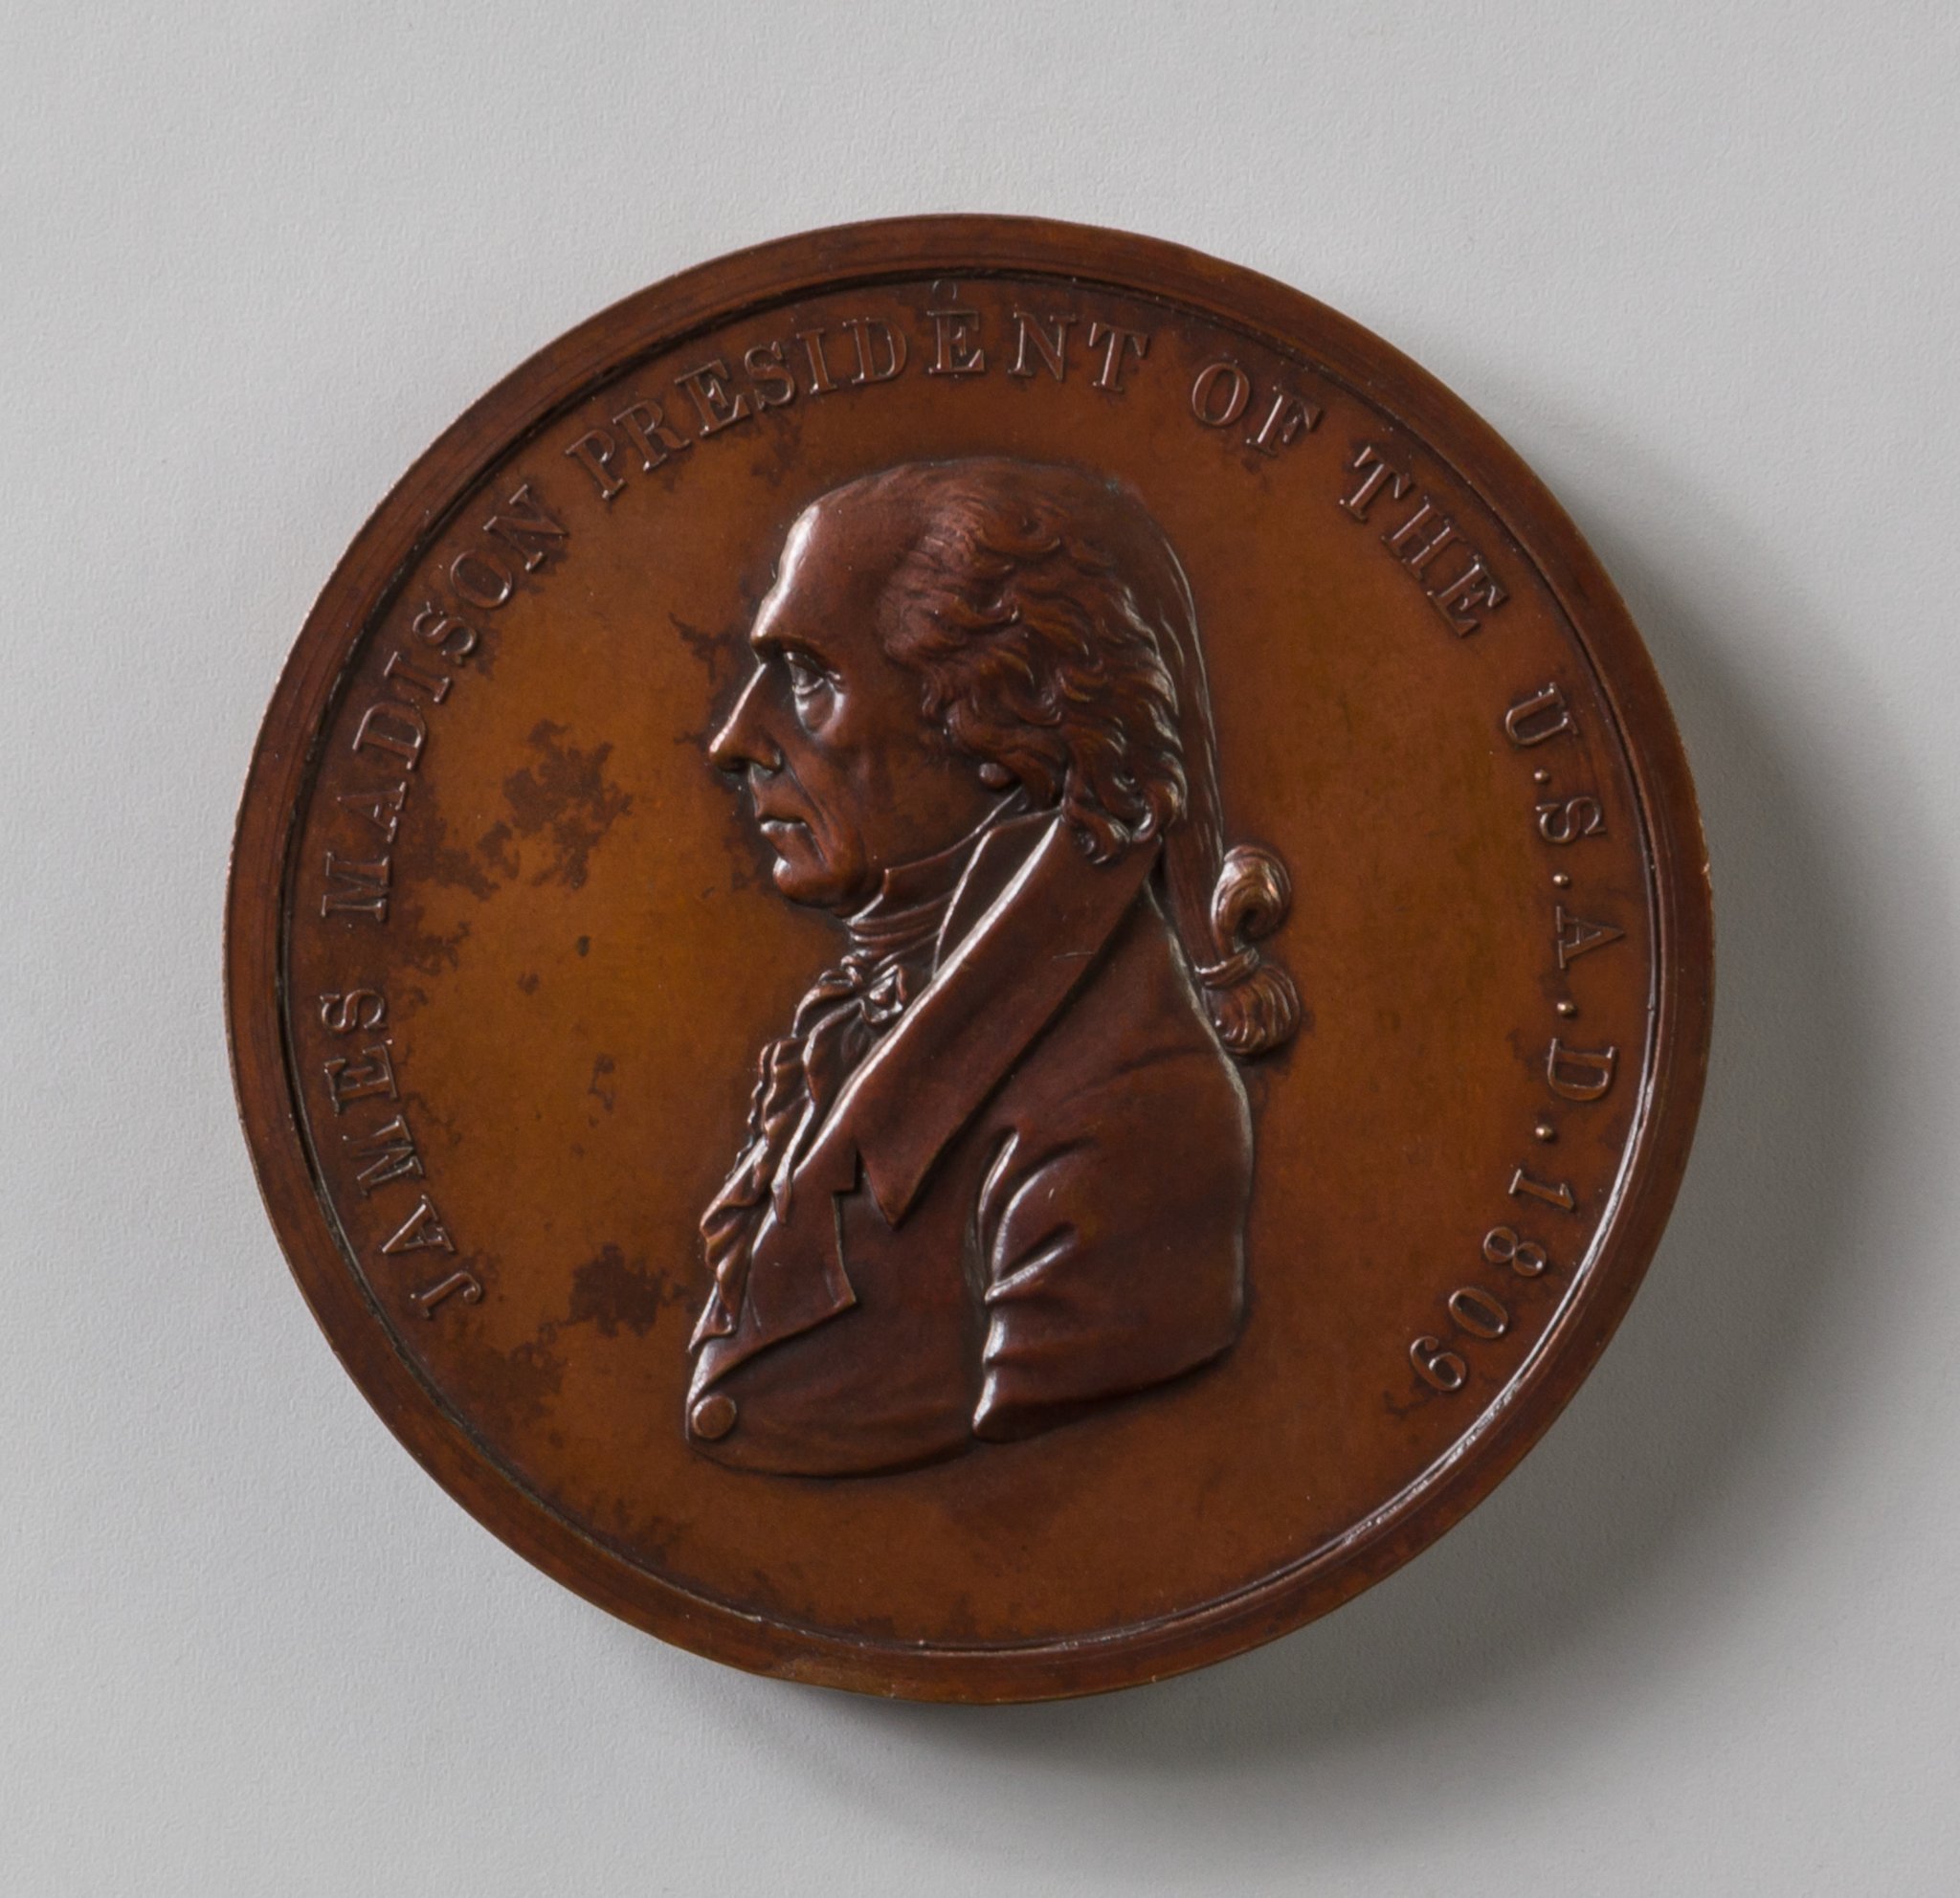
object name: medal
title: James Madison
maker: johann mathias reich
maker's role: artist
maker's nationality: american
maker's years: 1768-1833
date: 1801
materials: bronze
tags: men,profiles